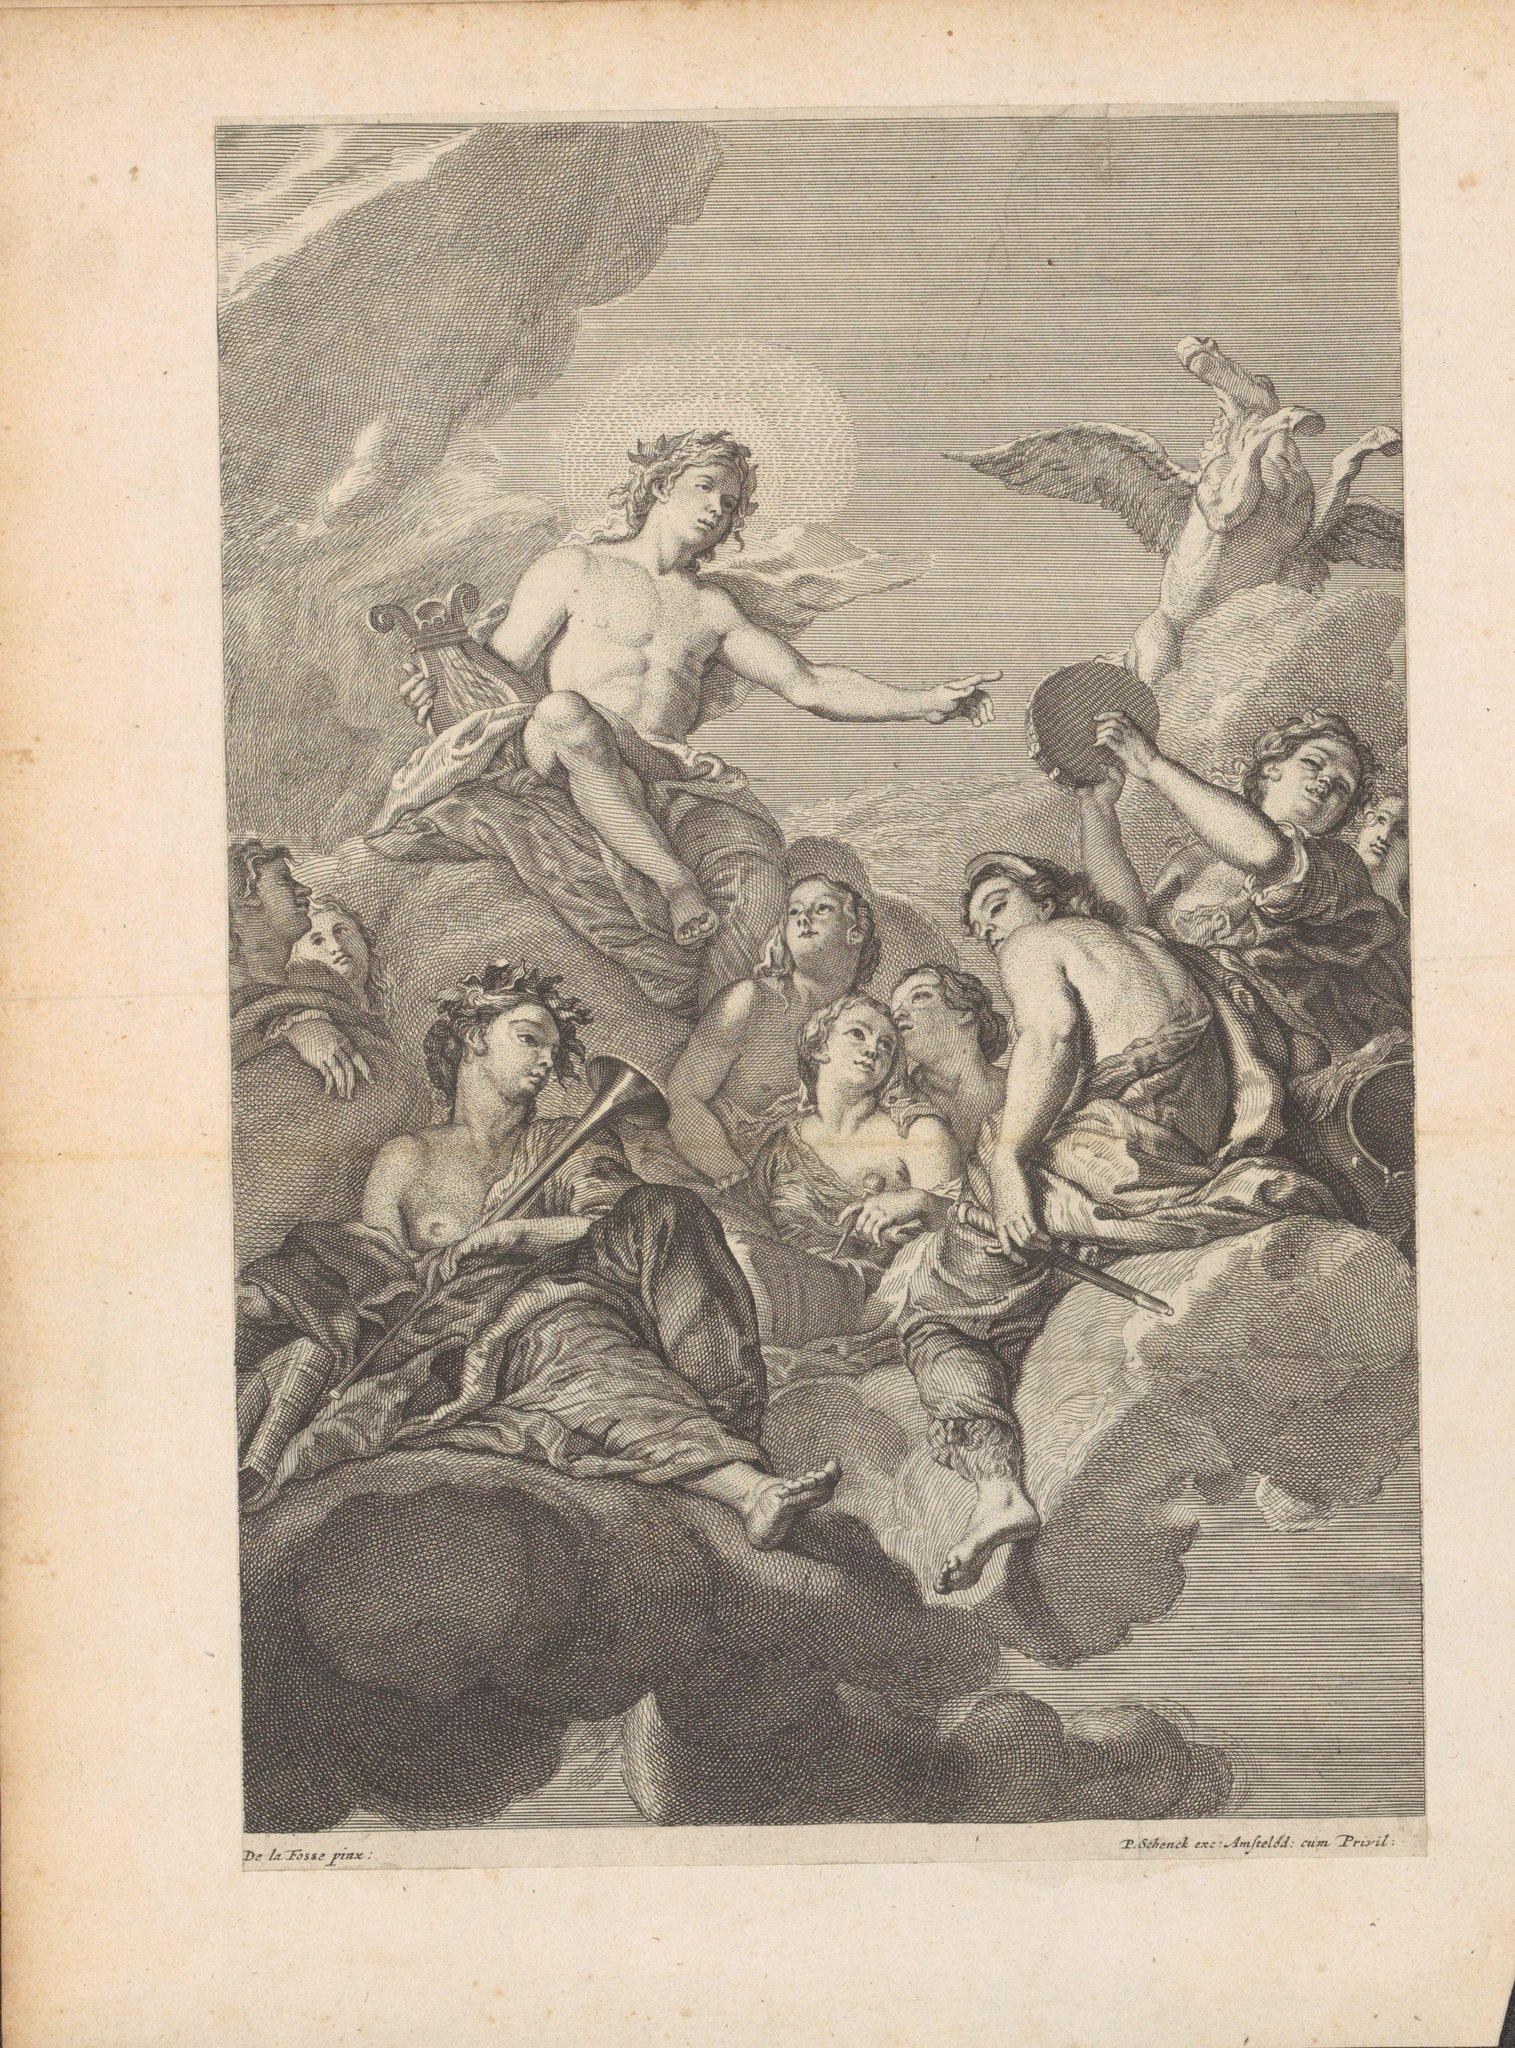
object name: album leaf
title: Le Cabinet des Beaux Arts (...) / De Schatkamer der Vrye Konsten (...)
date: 1693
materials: paper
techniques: engraving, etching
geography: amsterdam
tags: apollo and the muses, apollo musagetes, (decorated) ceiling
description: Plafondstuk met de god Apollo, tronend op de wolken met de lier in zijn hand, te midden van de muzen. Rechtsboven zijn gevleugelde paard Pegasus. Prent maakt deel uit van een album.